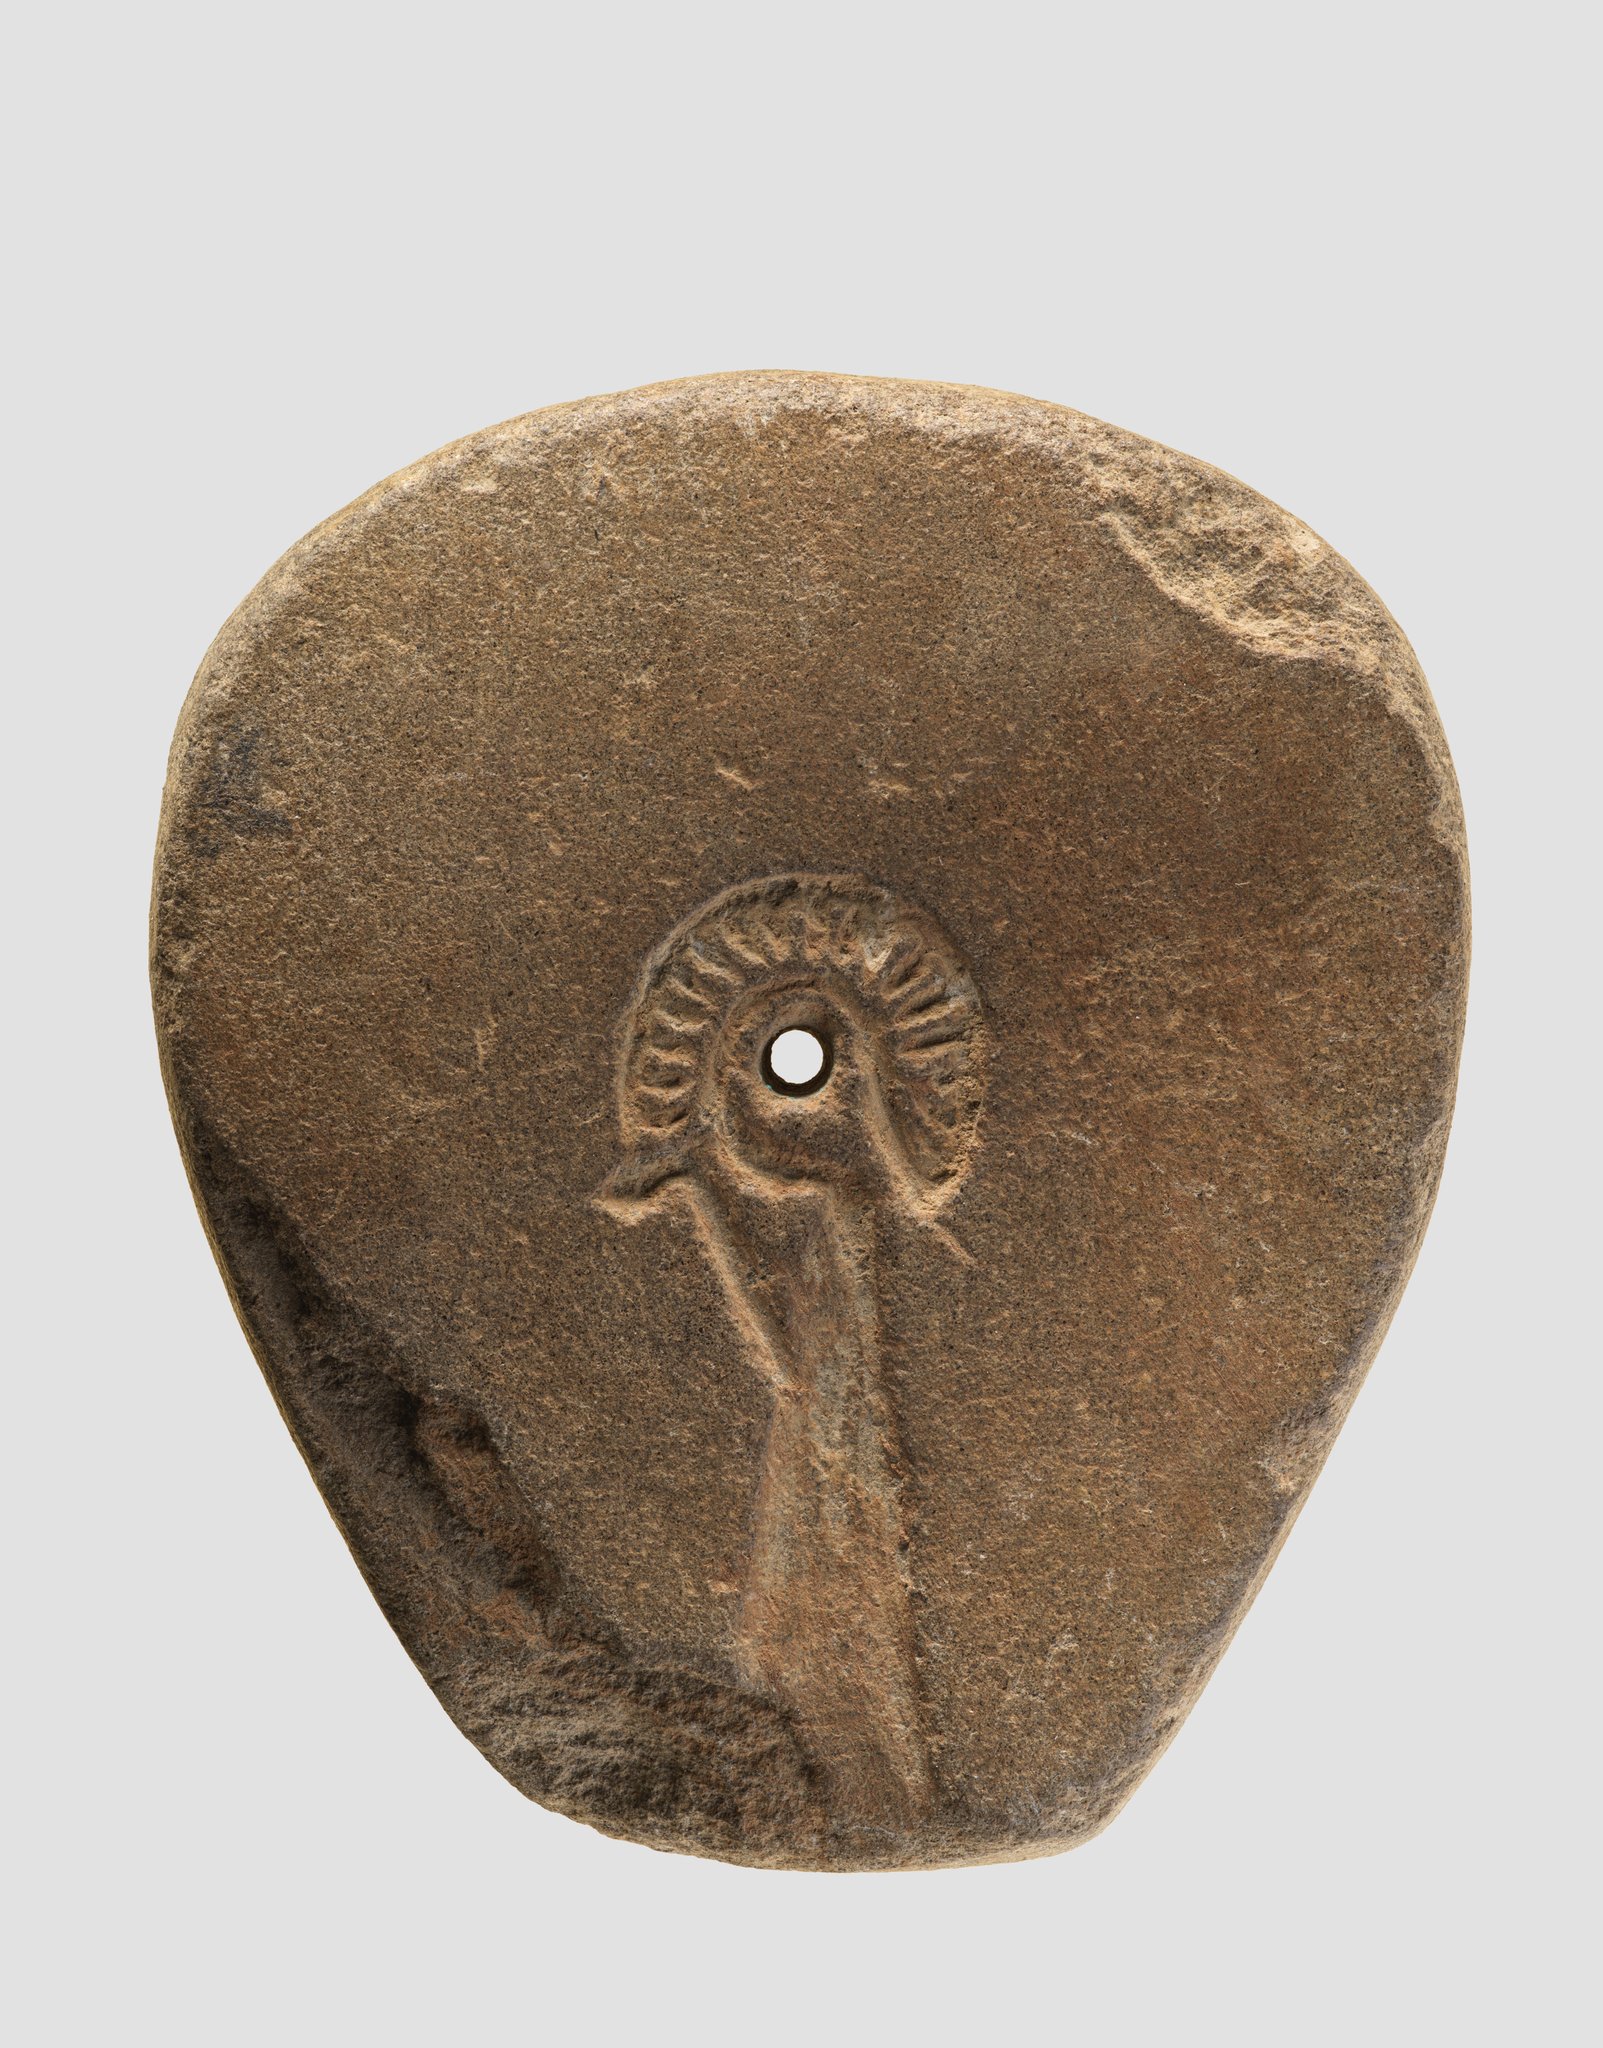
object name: mold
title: Jewelry mold fragment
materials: stone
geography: syria